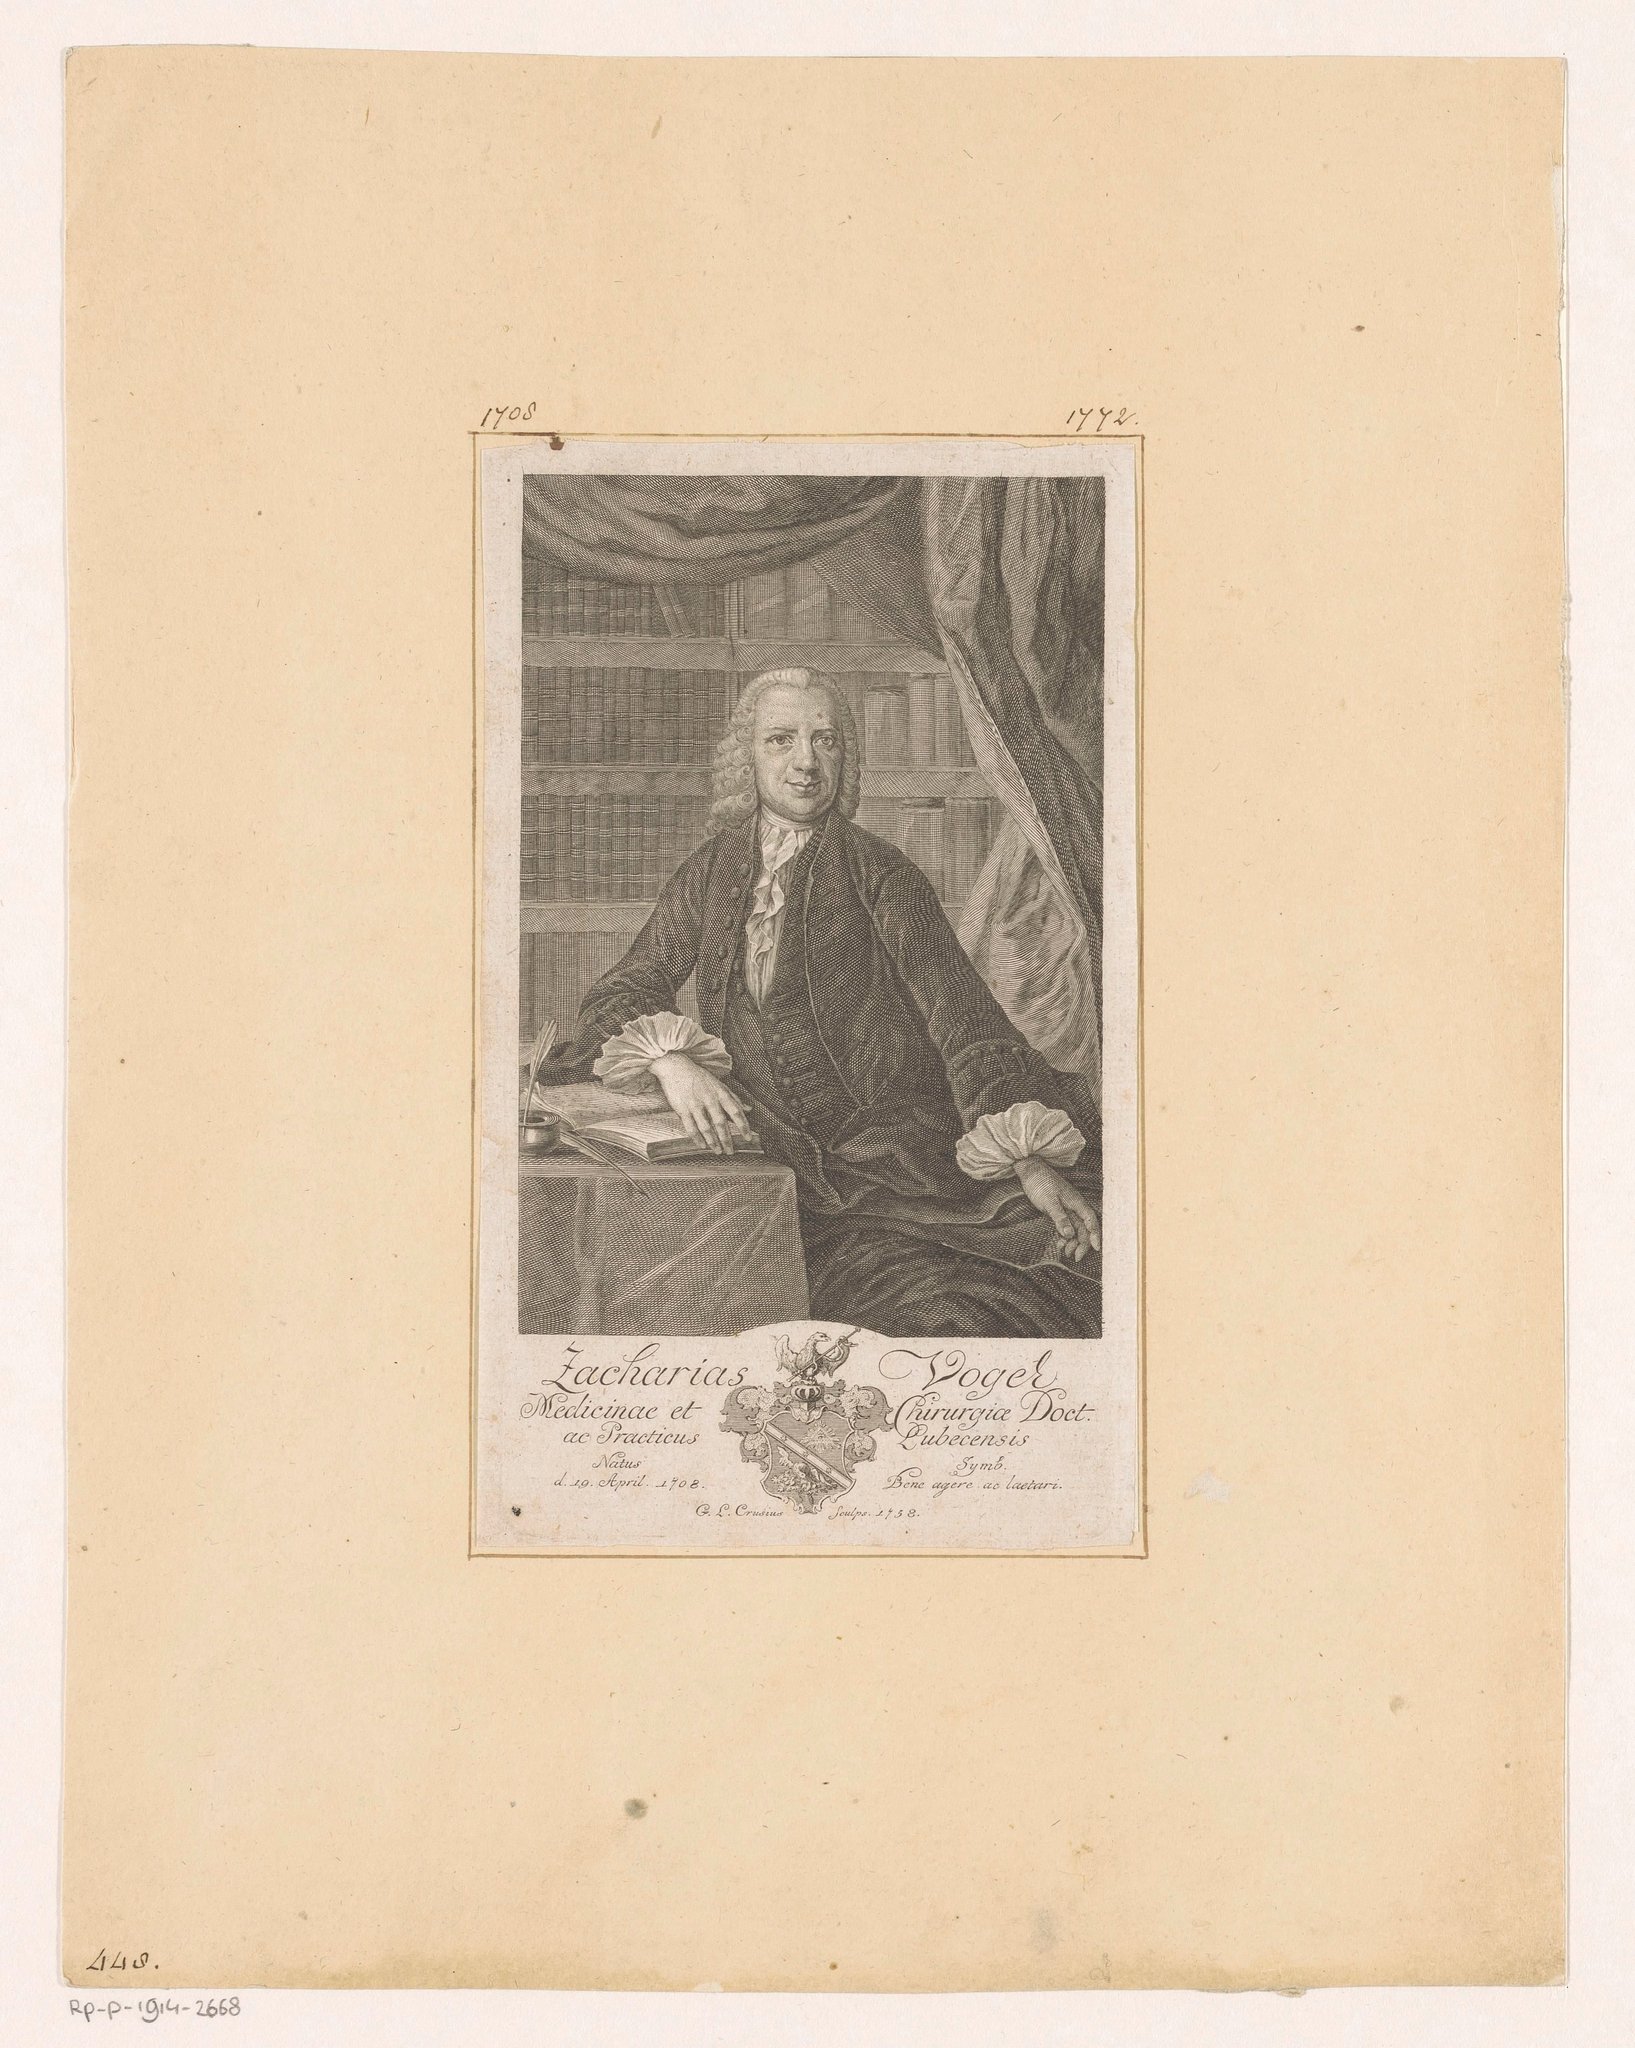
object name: print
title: Zacharias Vogel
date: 1758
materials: paper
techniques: engraving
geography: rostock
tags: historical persons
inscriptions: date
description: Prent uit: Vogel, Zacharias, Anatomische, Chirurgische und Medicinische Beobachtungen und Untersuchungen (...). Rostock: Johann Christian Koppe, 1759.